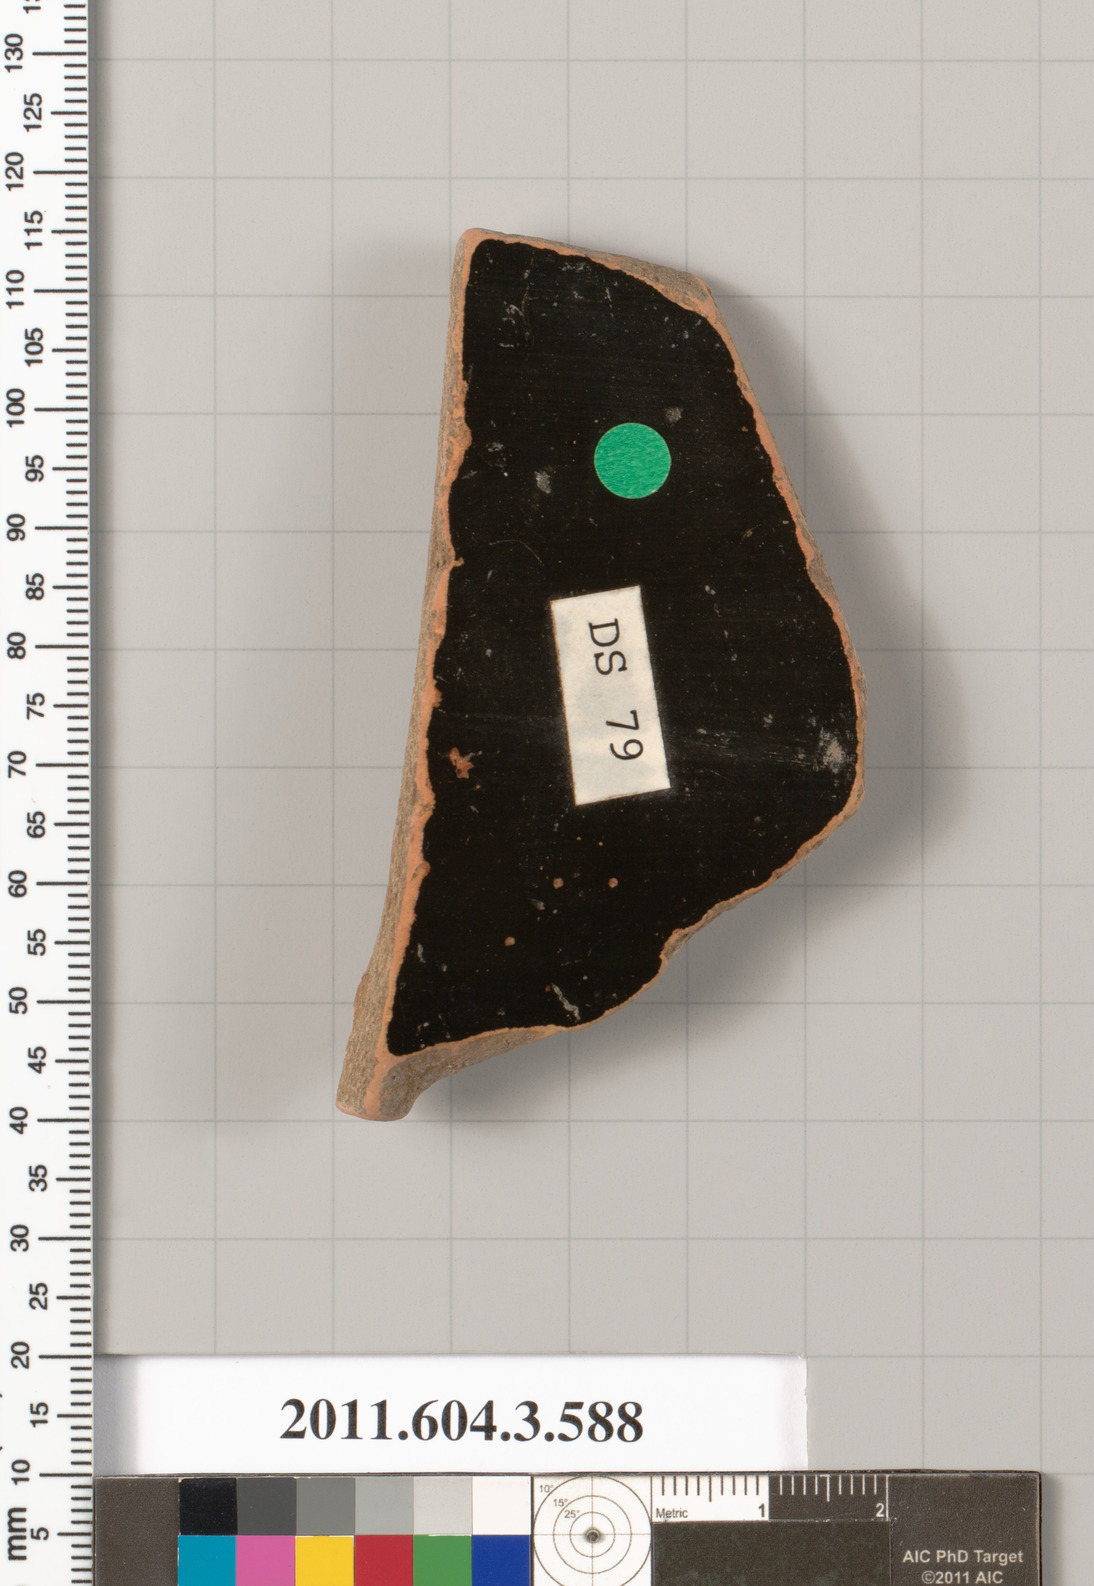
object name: column krater fragment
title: Terracotta fragment of a column-krater (bowl for mixing wine and water)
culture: greek, attic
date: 600-401 BCE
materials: terracotta